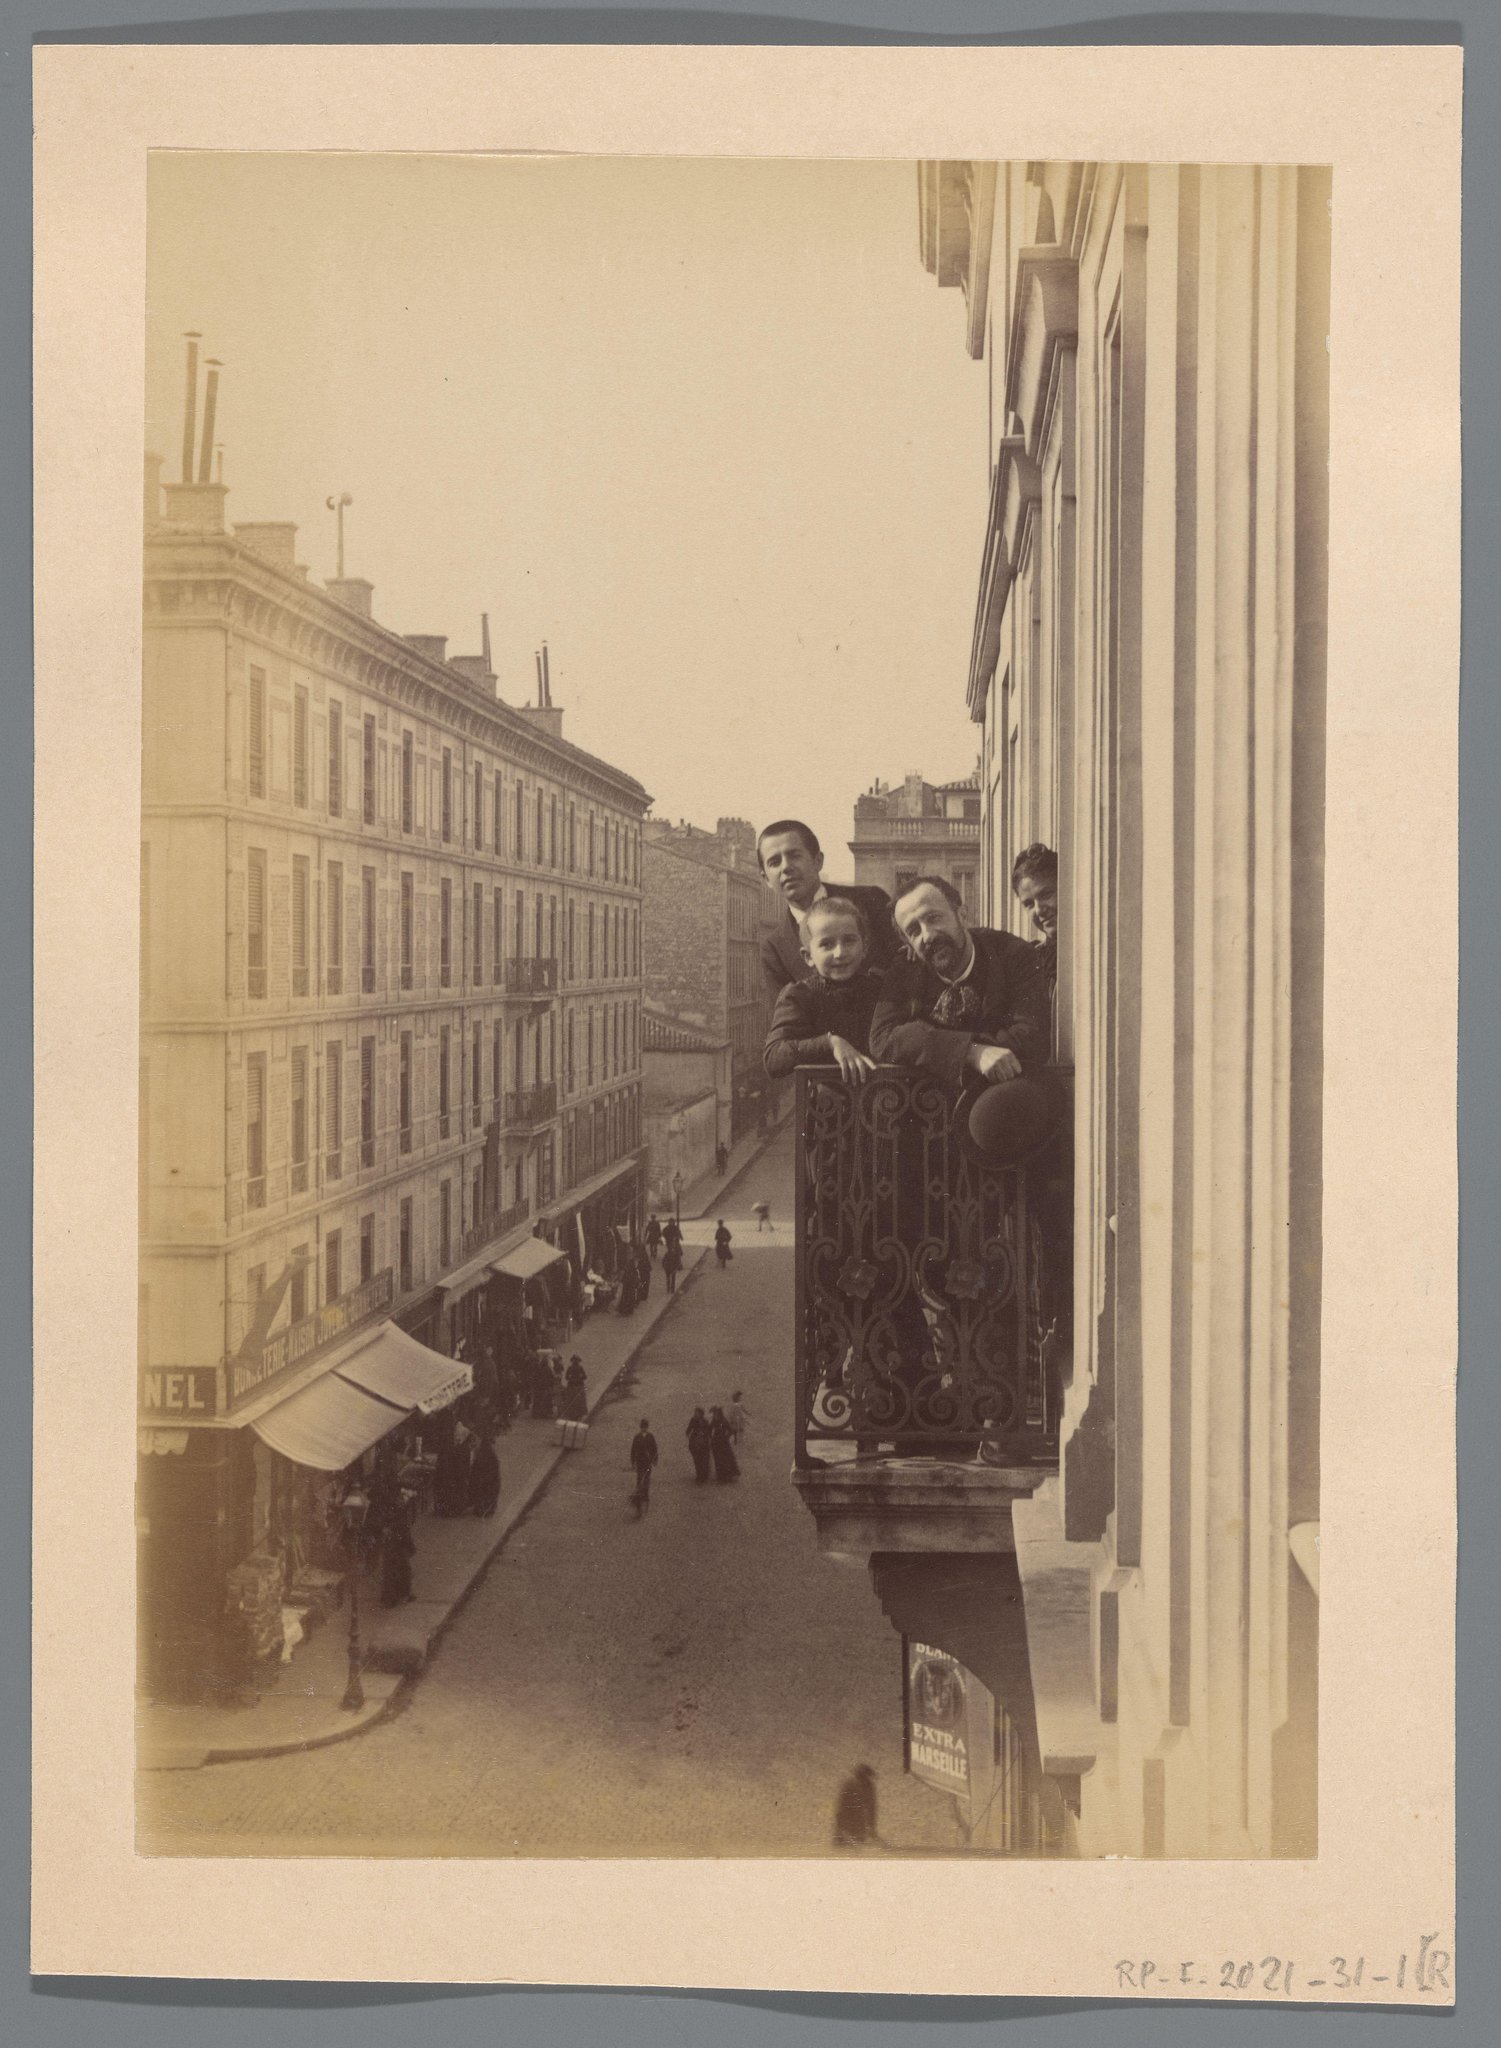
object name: photograph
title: Balkonscene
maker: Anonymous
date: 1850-1899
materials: photographic support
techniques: albumen print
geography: france